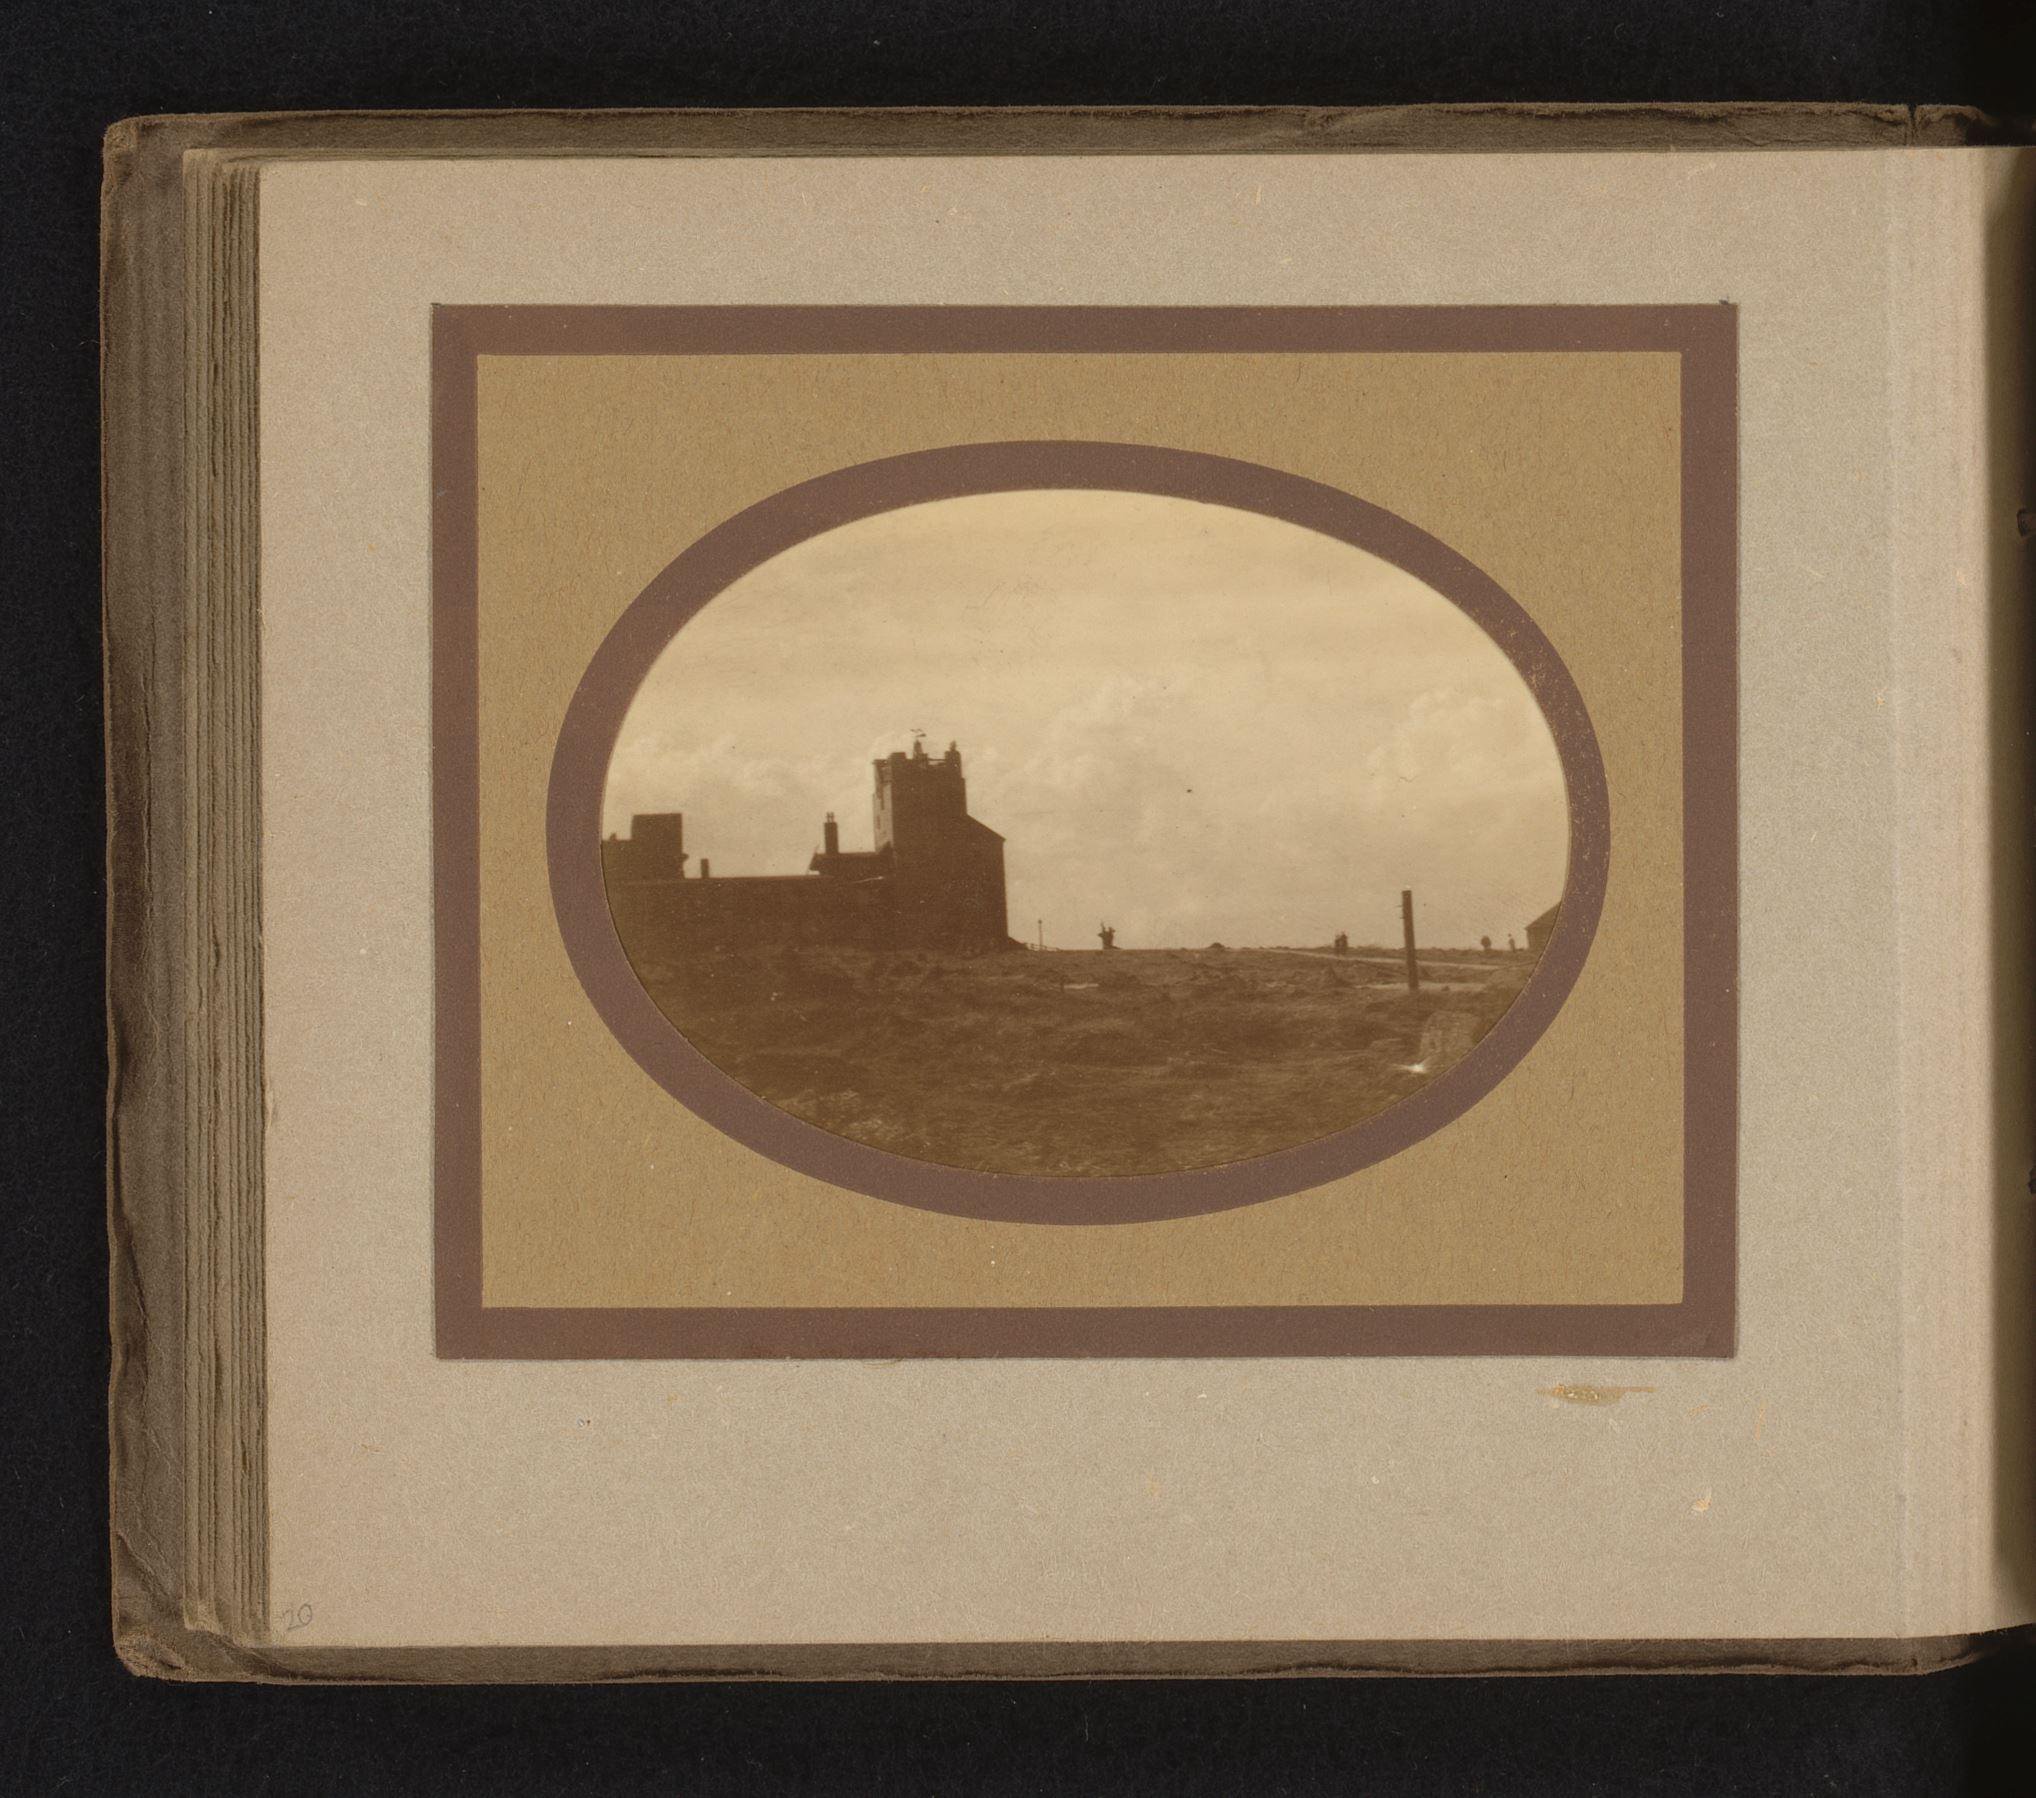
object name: photograph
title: Gezicht op een gebouw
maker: Anonymous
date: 1900-1930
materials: photographic support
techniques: daylight paper print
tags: civic architecture; edifices; dwellings